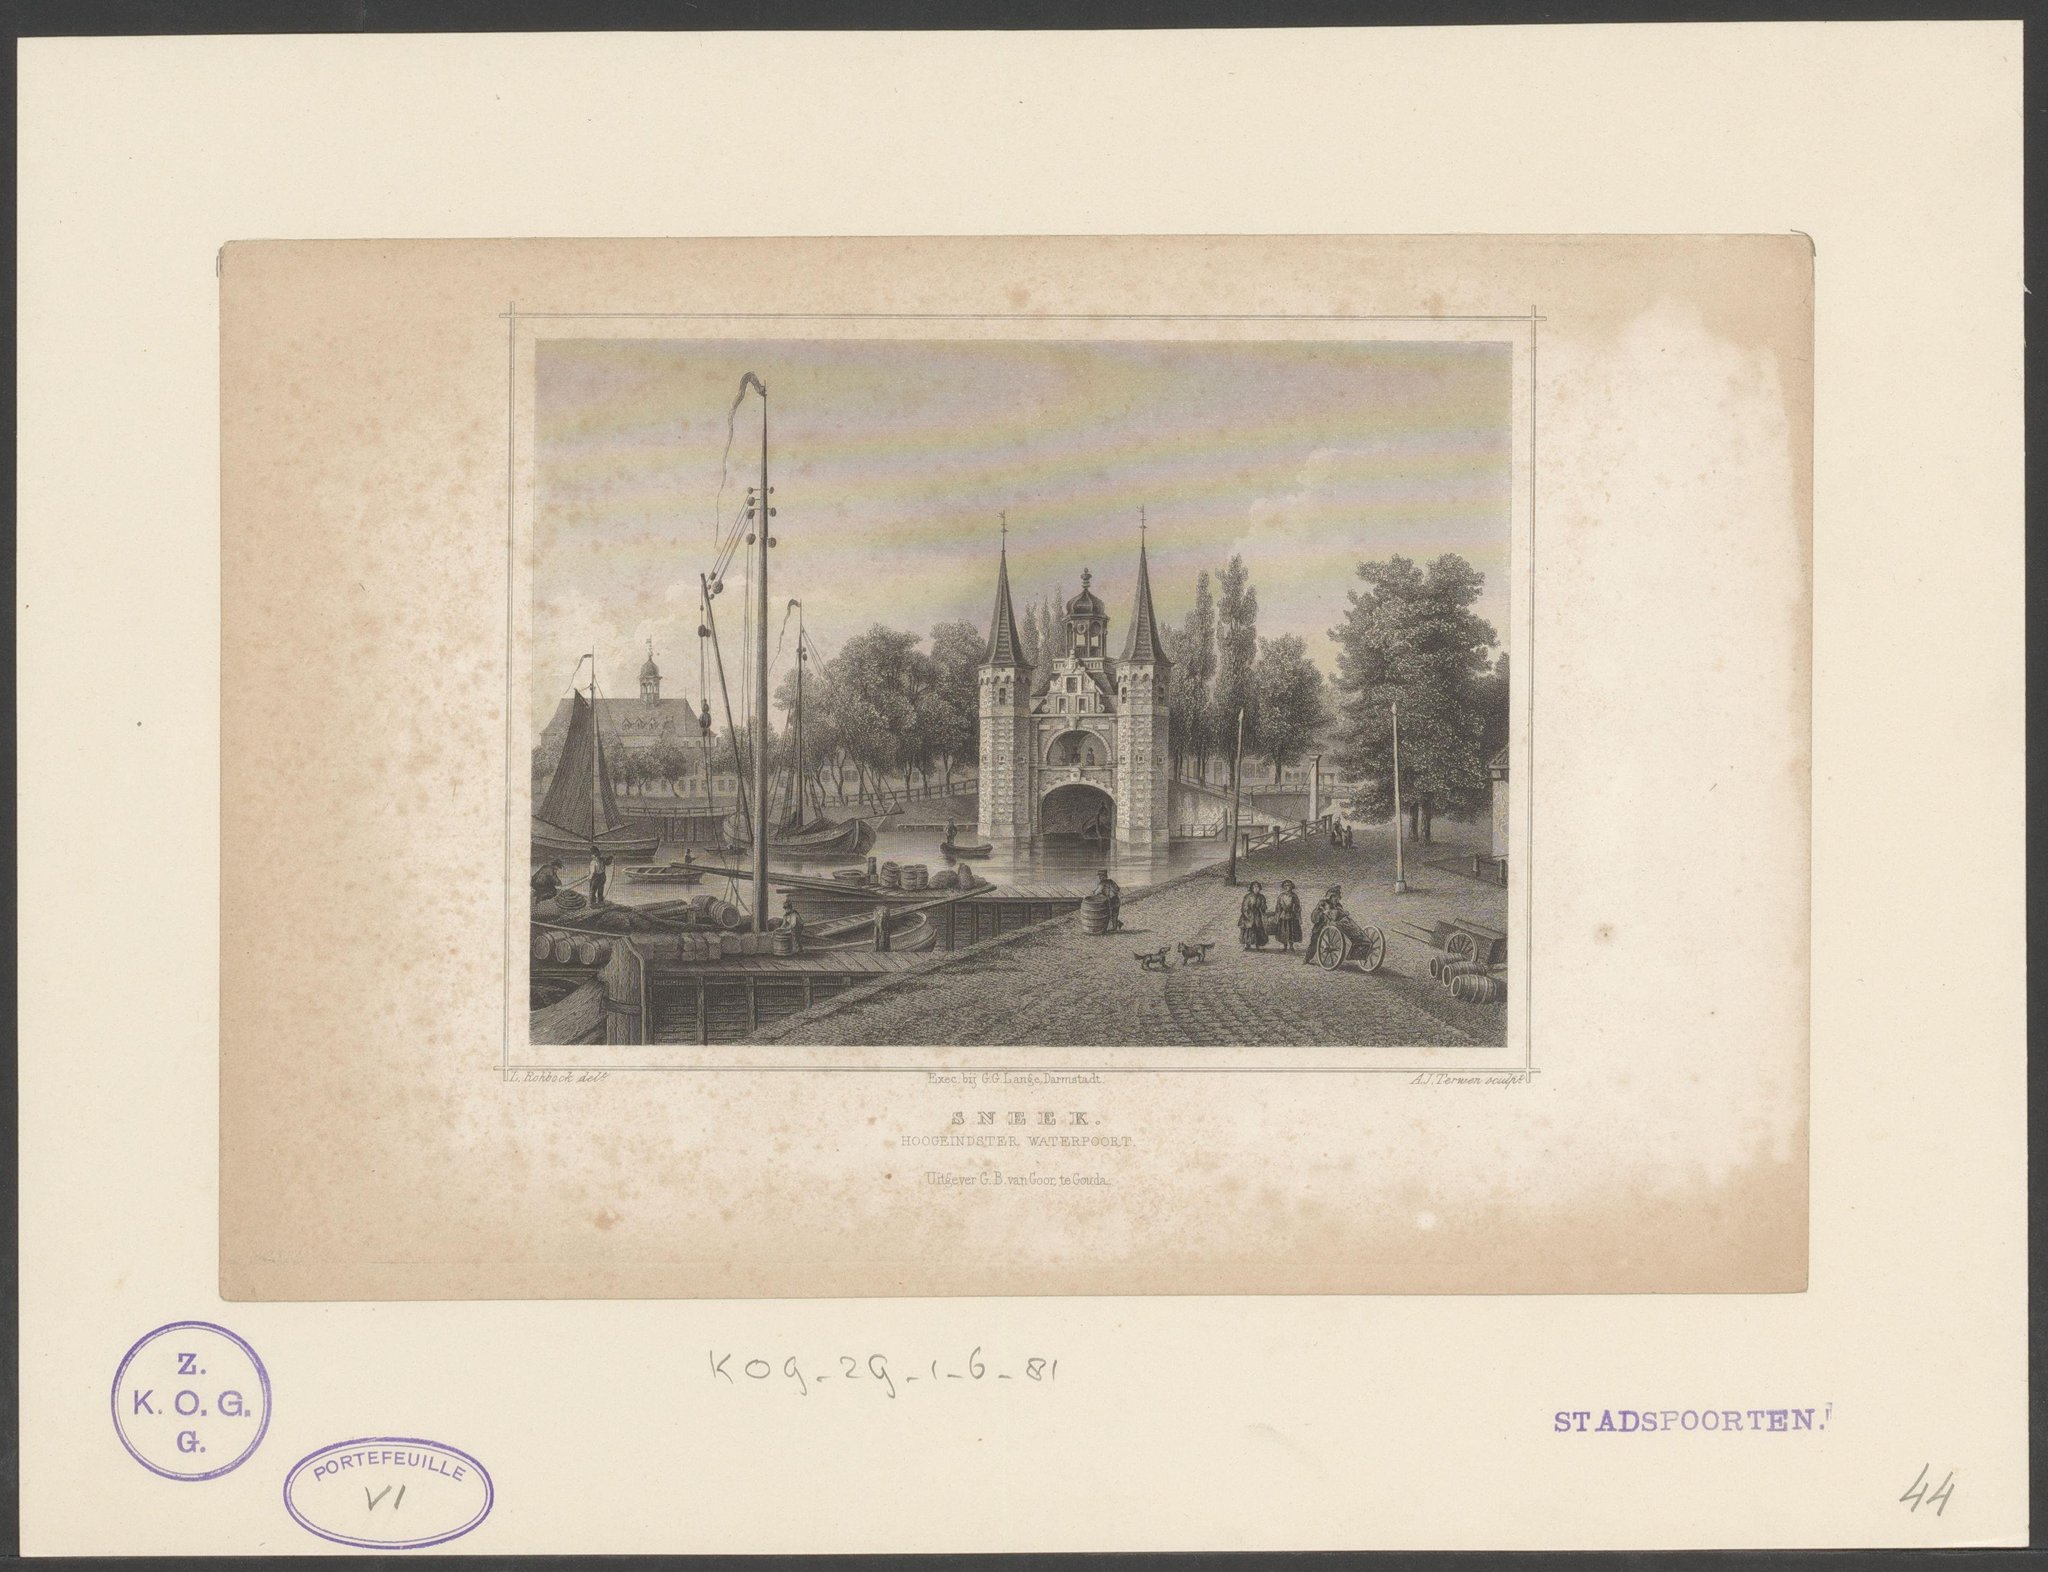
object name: print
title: Sneek. Hoogeindster waterpoort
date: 1864-1866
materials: paper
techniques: engraving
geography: darmstadt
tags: harbour, city-gate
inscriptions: stamp, collector's mark: Lugt 1641, stamp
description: Prent mogelijk uit: Terwen, Johannes Leonardus. Het Koninkrijk der Nederlanden, voorgesteld in eene reeks van naar de natuur geteekende schilderachtige gezigten (...). Gouda: G.B. van Goor, 1866, dl. 3.